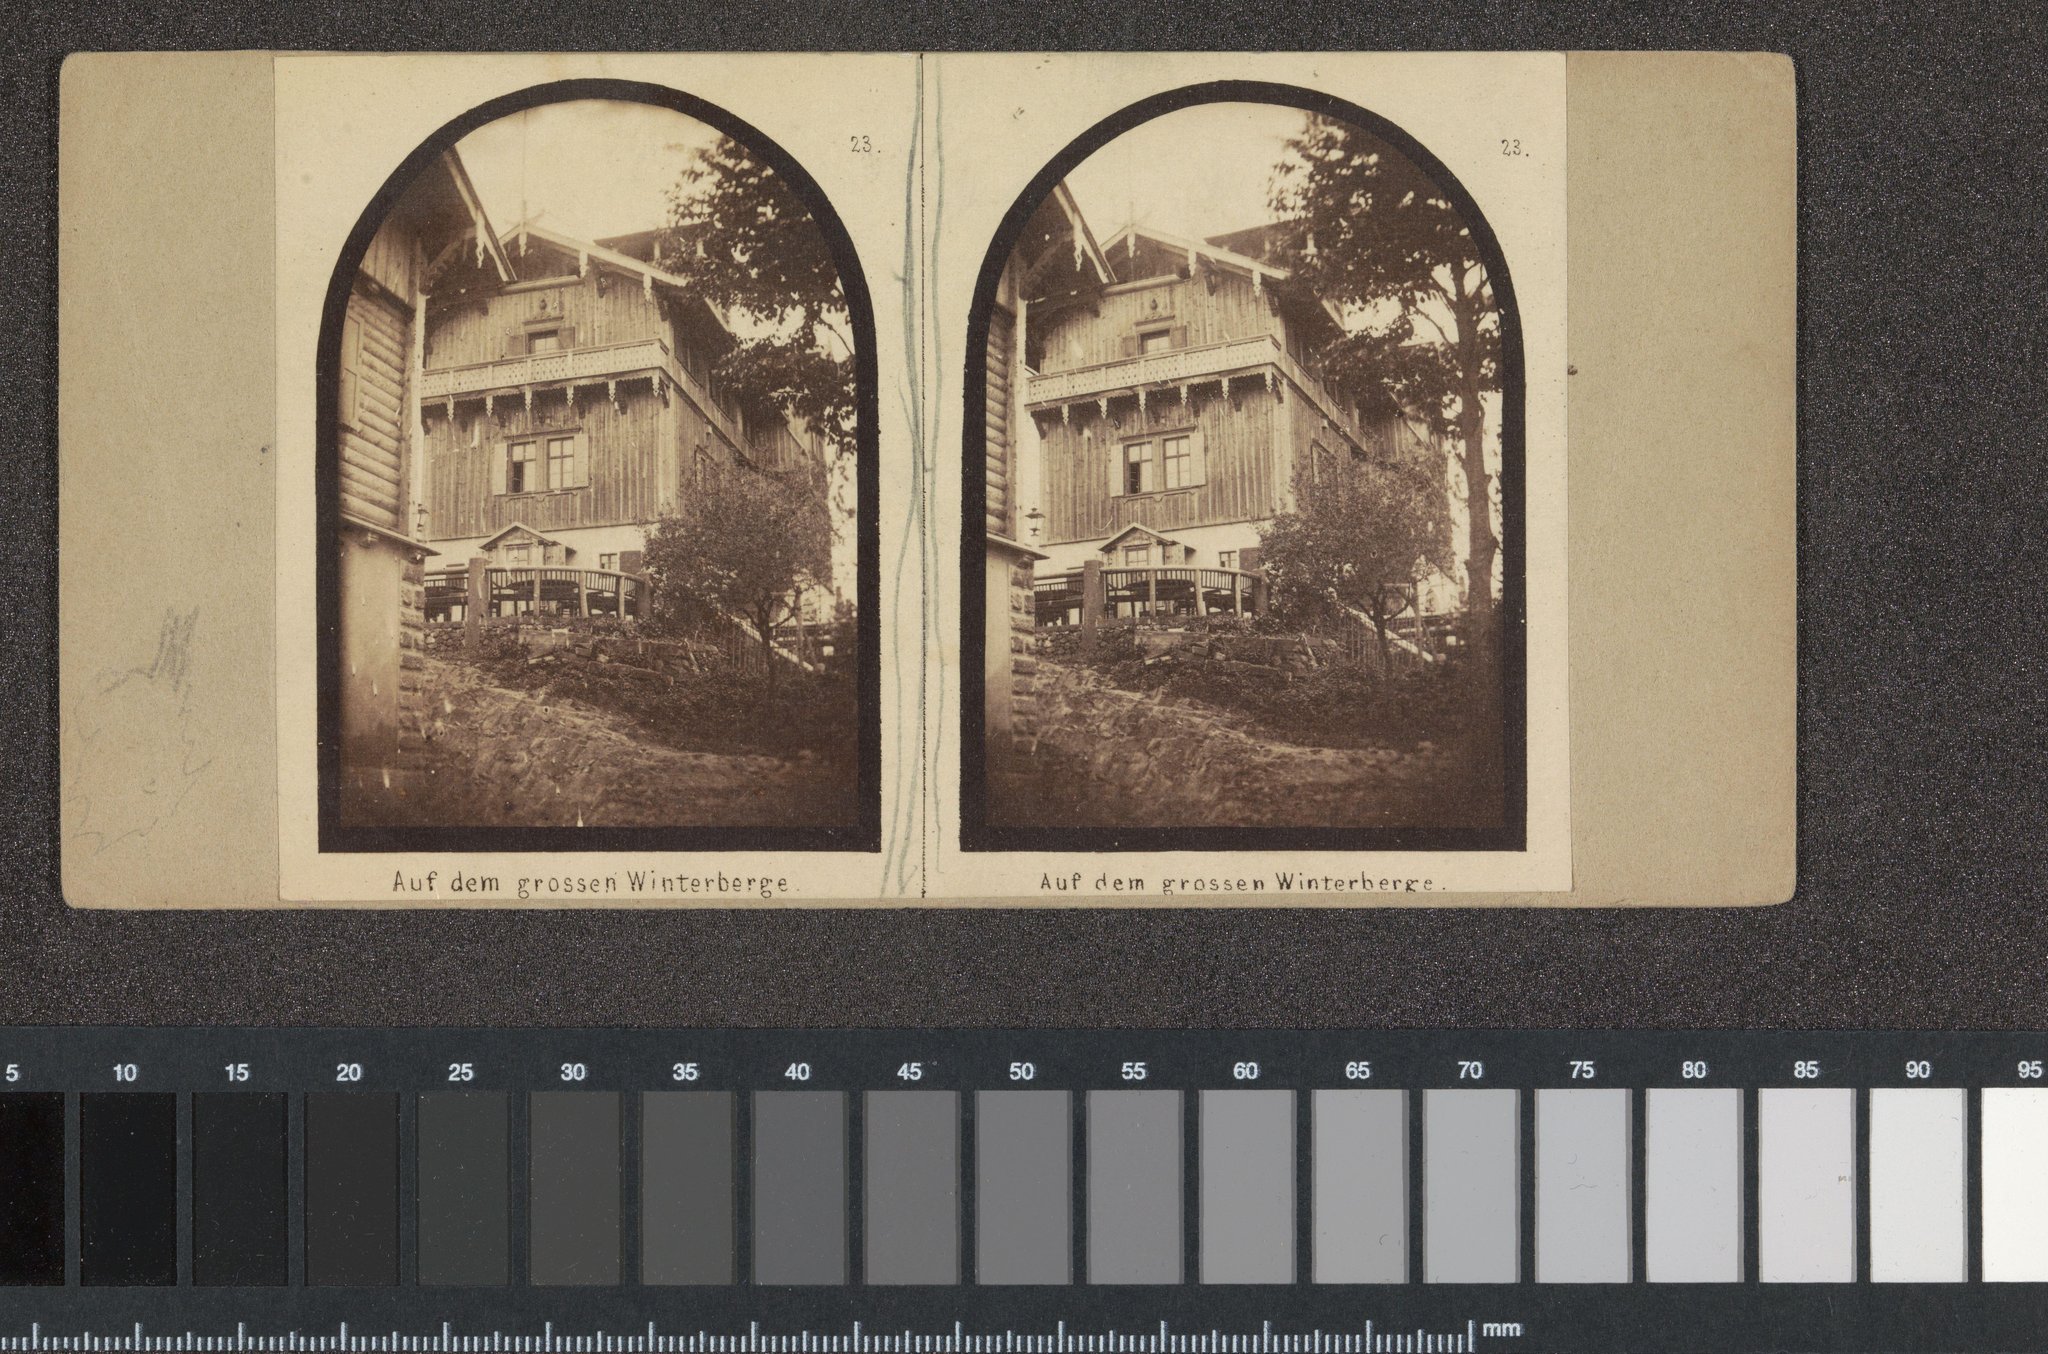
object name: stereograph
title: Gebouwen op de Großer Winterberg in Duitsland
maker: Anonymous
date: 1855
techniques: albumen print, salted paper print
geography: germany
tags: mountains